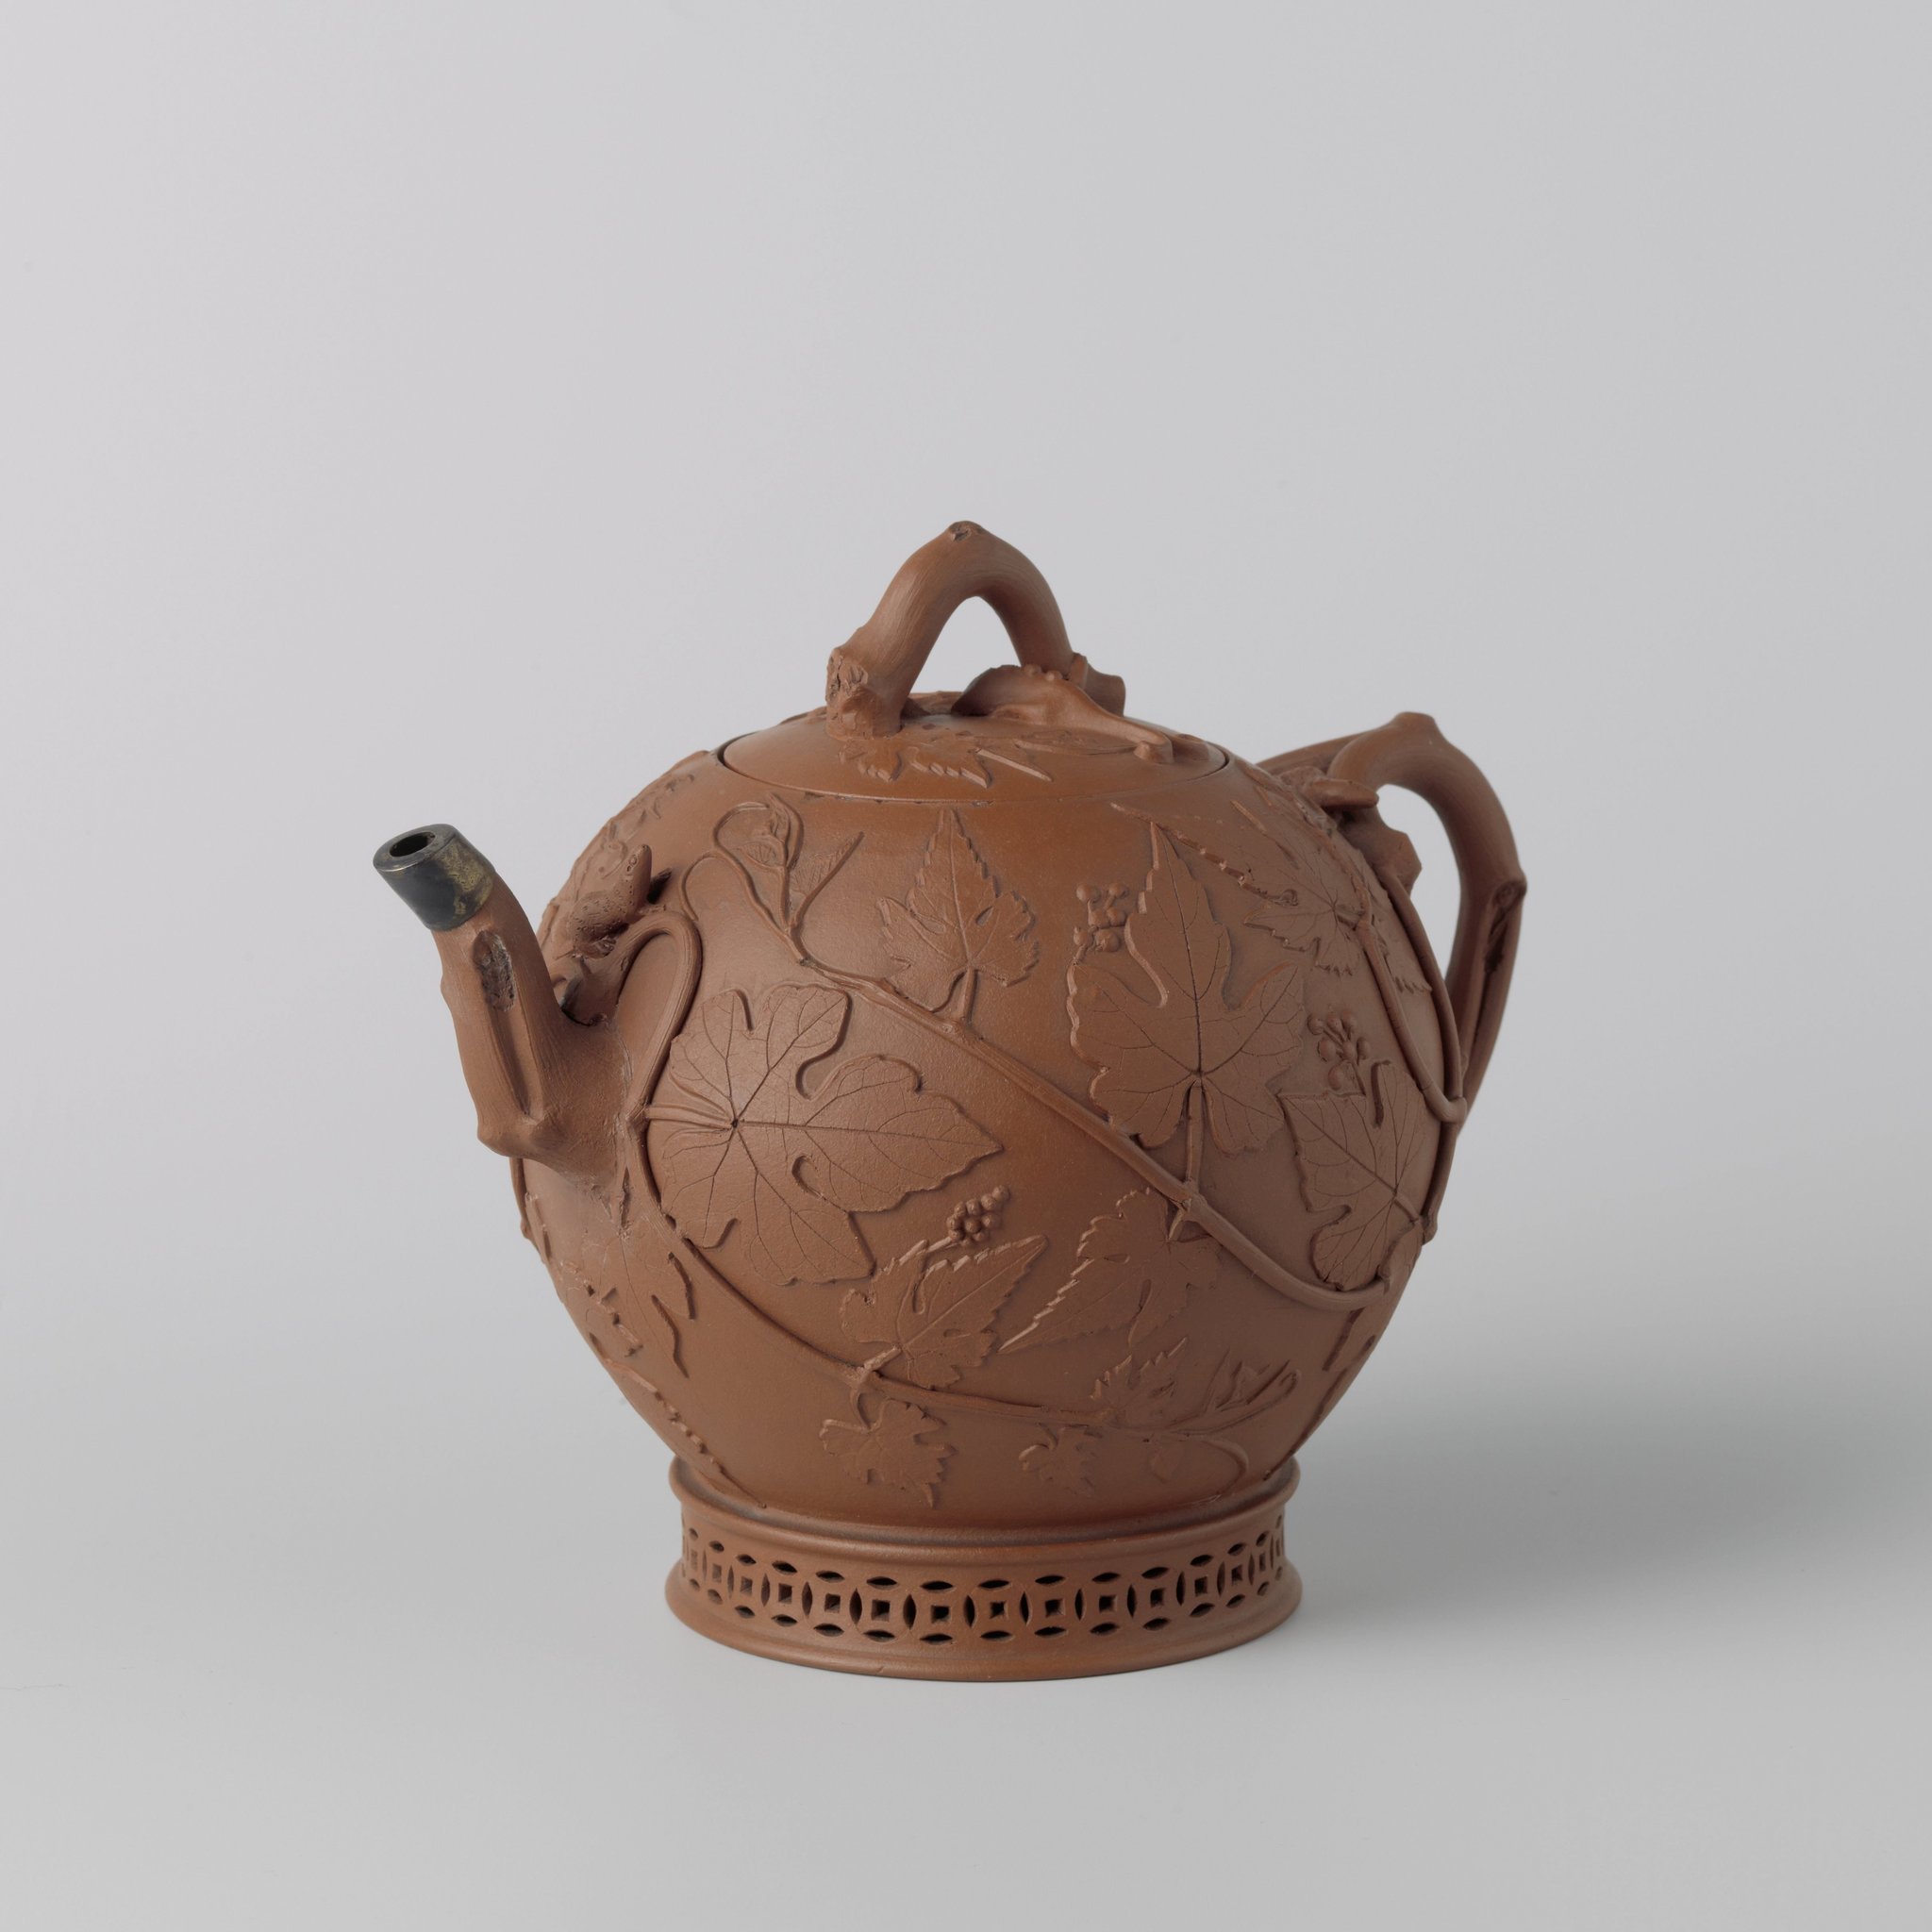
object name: teapot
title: Teapot with grapevines and squirrels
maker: Anonymous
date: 1675-1699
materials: silver, stoneware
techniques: firing, forming, relief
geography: china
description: Theepot van rood steengoed op een hoge, opengewerkte voet en de gebogen tuit, C-vormig oor en dekselknop in de vorm van knoestige takken. De wand is bedekt met druivenranken en drie eekhoorns in reliëf: één boven de tuit en twee bij het oor. De deksel met bladranken. De tuit is voorzien van een zilveren montuur. Yixing.